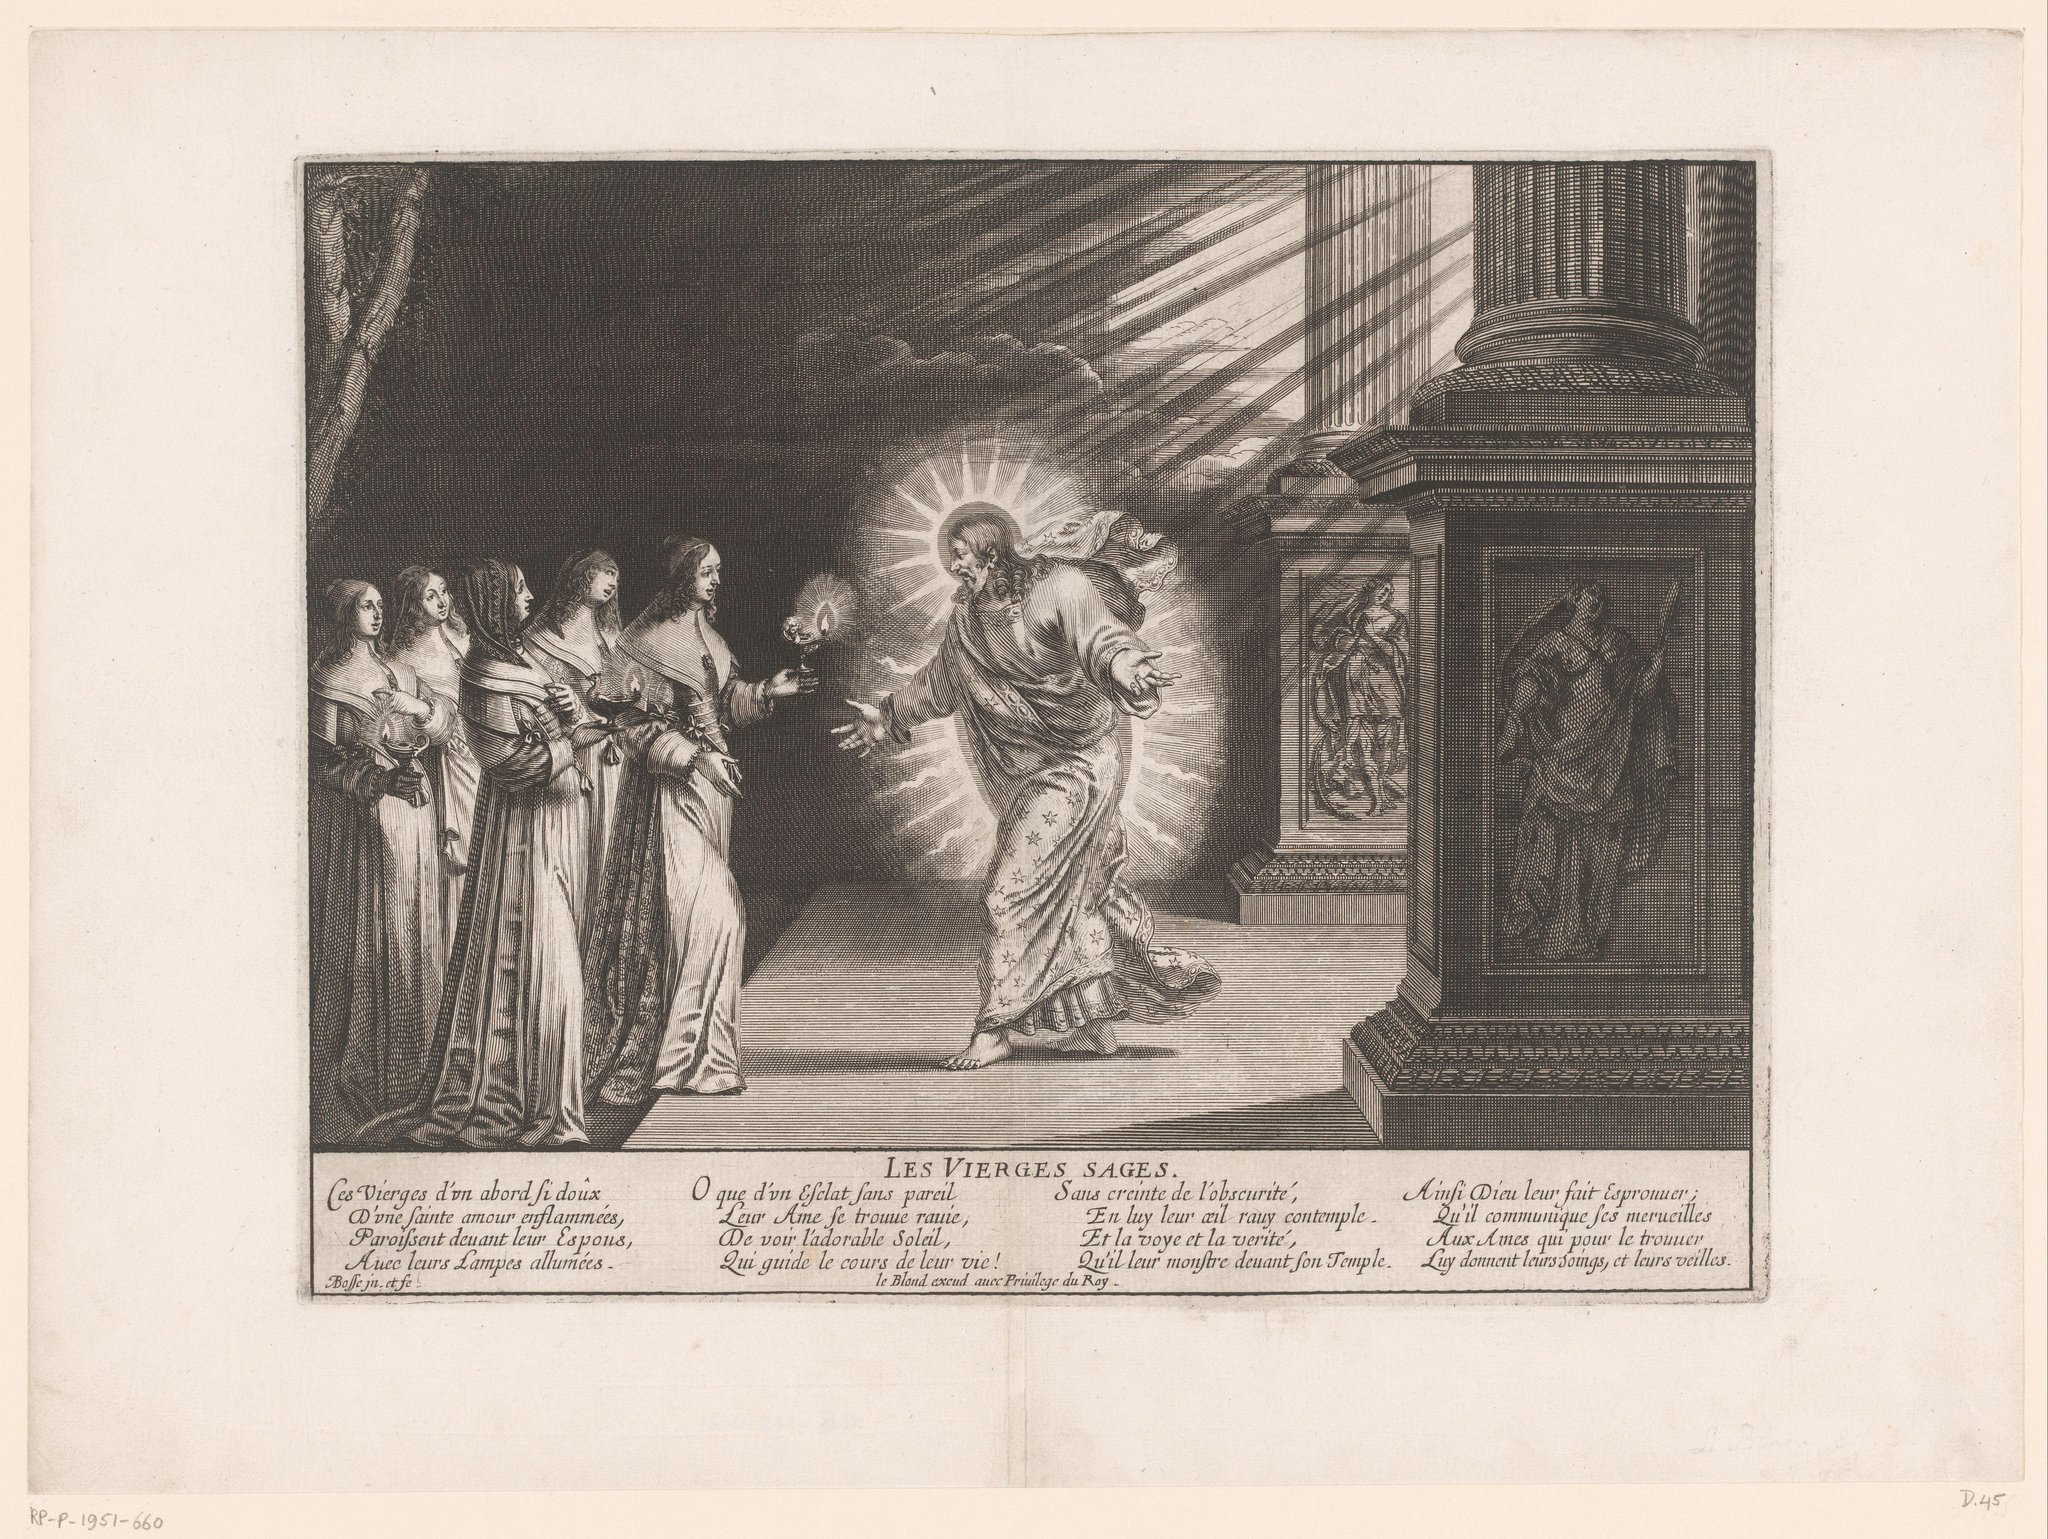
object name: print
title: Vijf wijze maagden verschijnen met lamp voor hun bruidegom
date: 1638-1640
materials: paper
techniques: engraving, etching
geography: paris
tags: the wise virgins are let into the house with the bridegroom (christ); the foolish virgins are shut out, the wise and the foolish virgins ~ parable of christ (matthew 25:1-13), oil-lamp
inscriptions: collector's mark: Lugt 2228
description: Maakt deel uit van een serie van zeven prenten met als onderwerp de parabel van de vijf wijze en de vijf dwaze maagden. De eerste staat werd uitgegeven door Jean Leblond (I) en een tweede staat door de weduwe van Poilly.